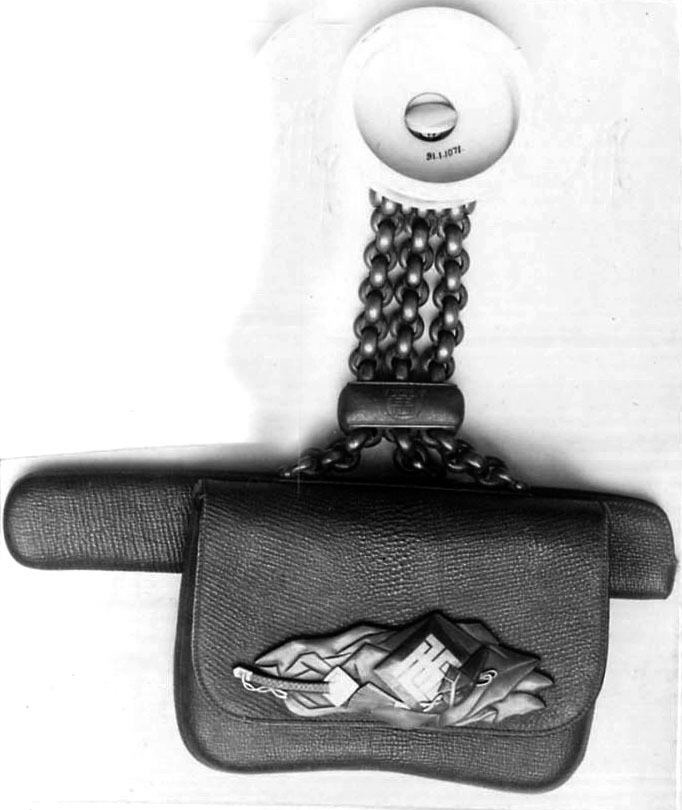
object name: tobacco pouch and pipe case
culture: japanese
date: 1801-1900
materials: ivory, leather, metal